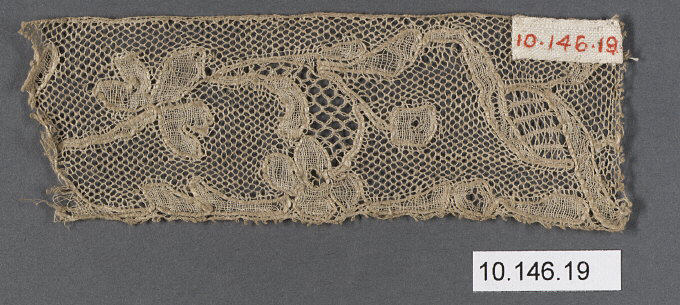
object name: fragment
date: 1701-1800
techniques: lace